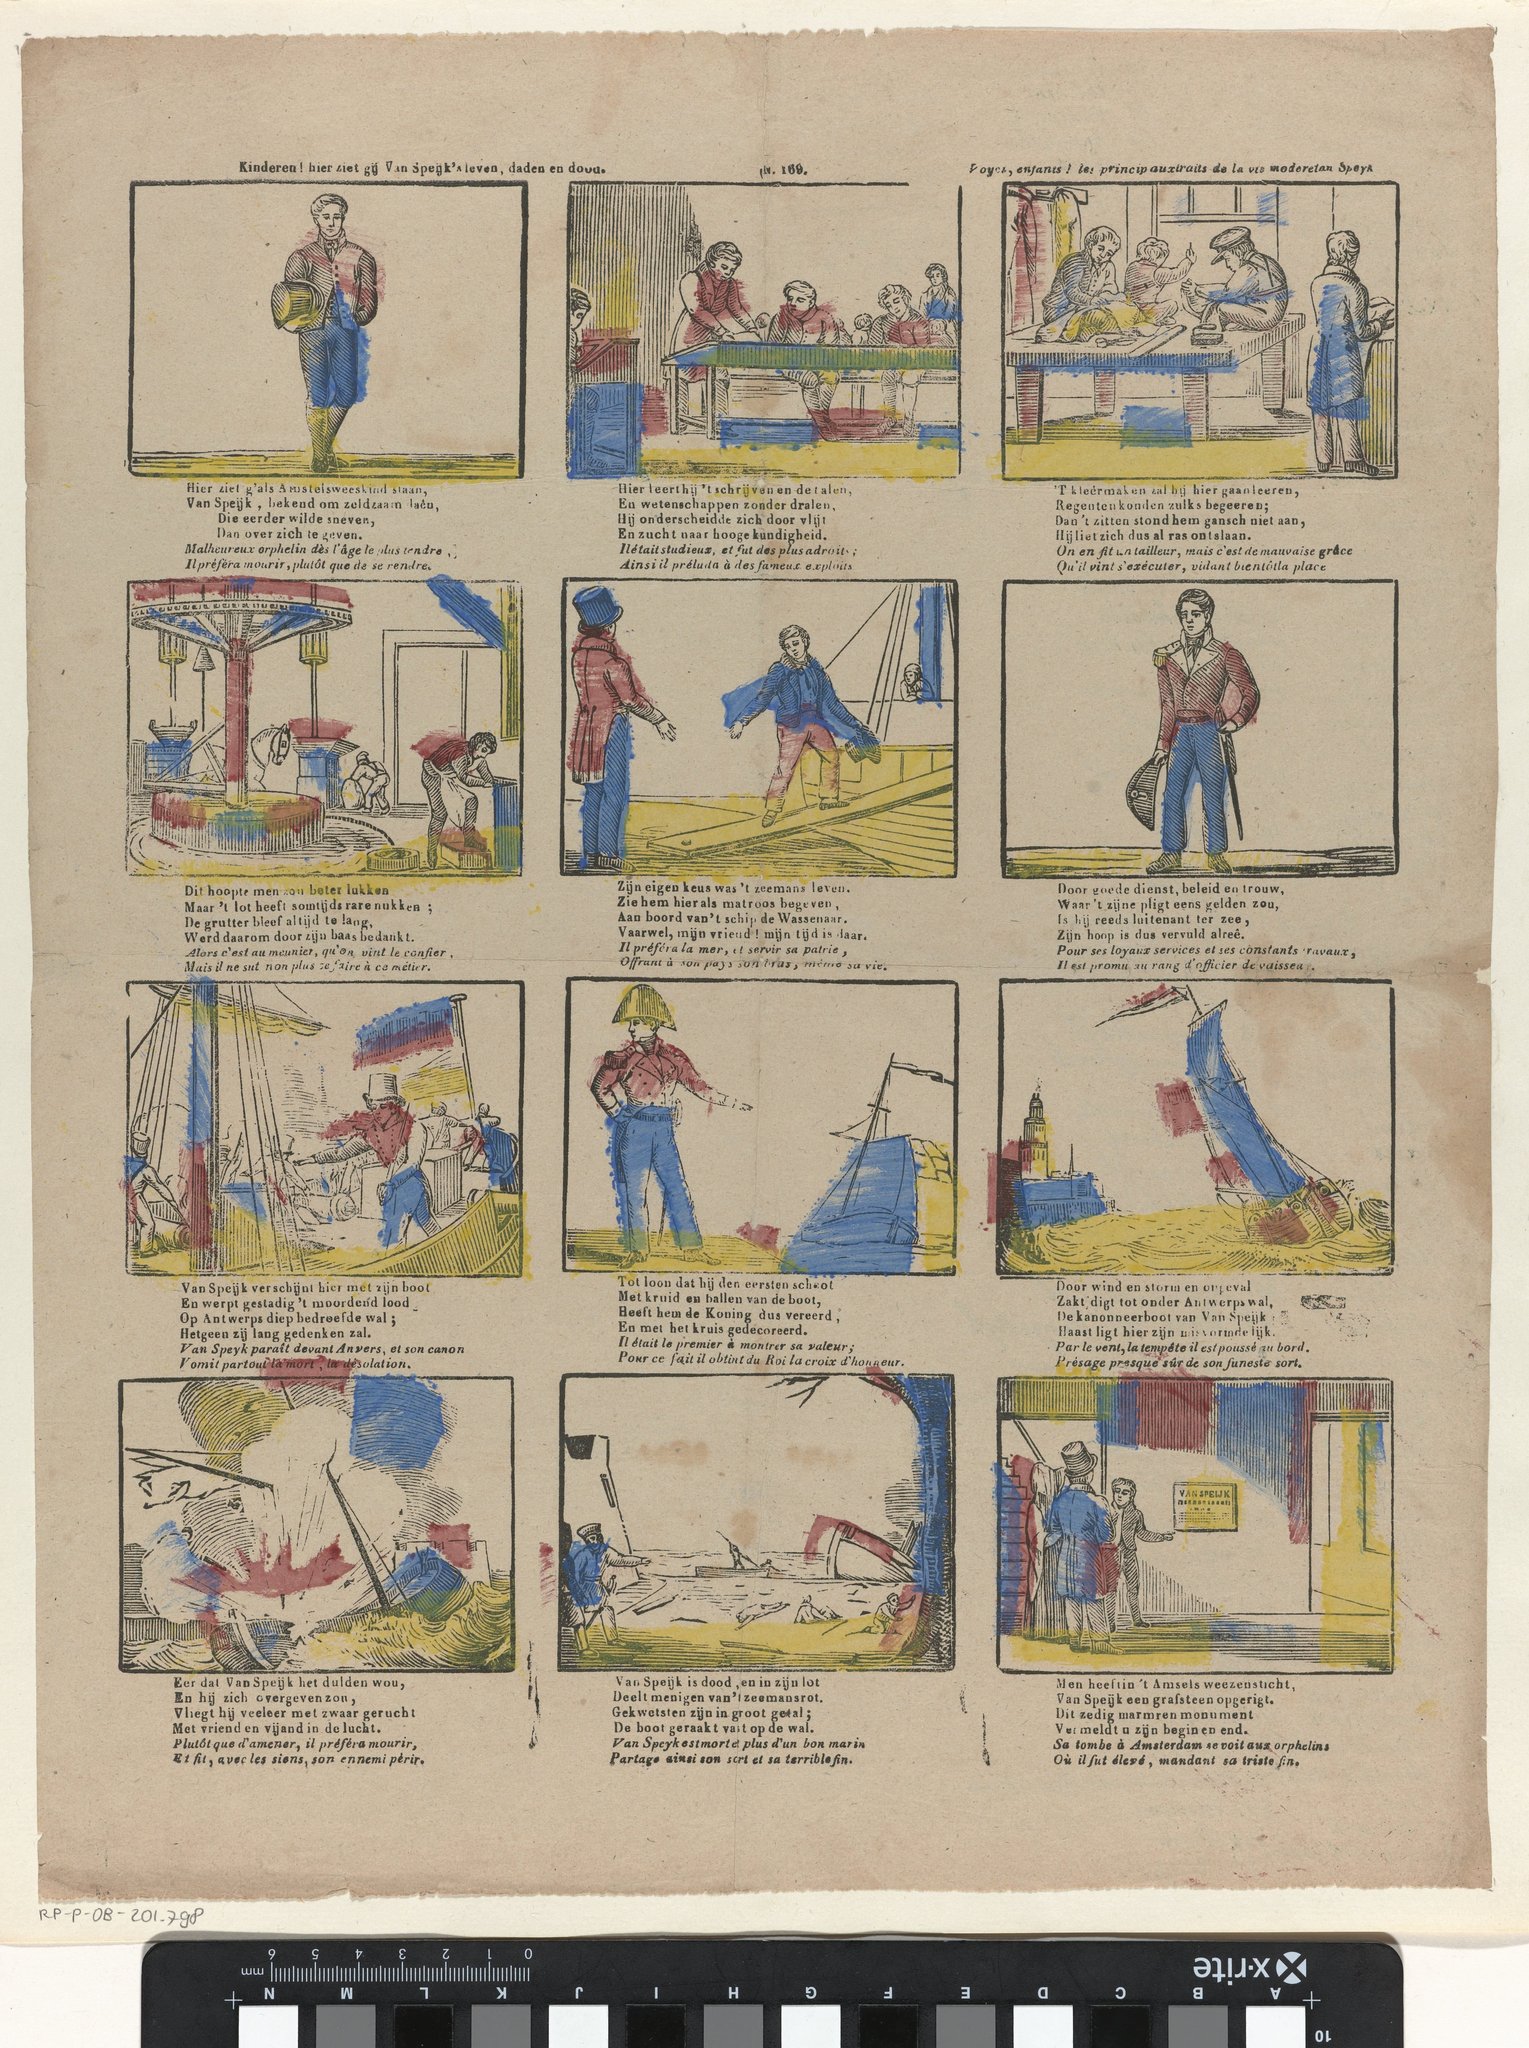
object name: print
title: Kinderen! hier ziet gij Van Speijk's leven, daden en dood [(...)]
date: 1800-1833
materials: paper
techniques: colour, letterpress printing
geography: turnhout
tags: amsterdam, antwerp, jan van speyk, battle, revolution, revolt, orphans, belgium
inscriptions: collector's mark: Lugt 2760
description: Blad met 12 voorstellingen over het leven en de zelfopoffering van J.C.J. van Speyk tijdens de strijd tegen de Belgen. Onder elke afbeelding een vierregelig vers in het Nederlands en een tweeregelig vers in het Frans. Genummerd midden boven: (N. 169.